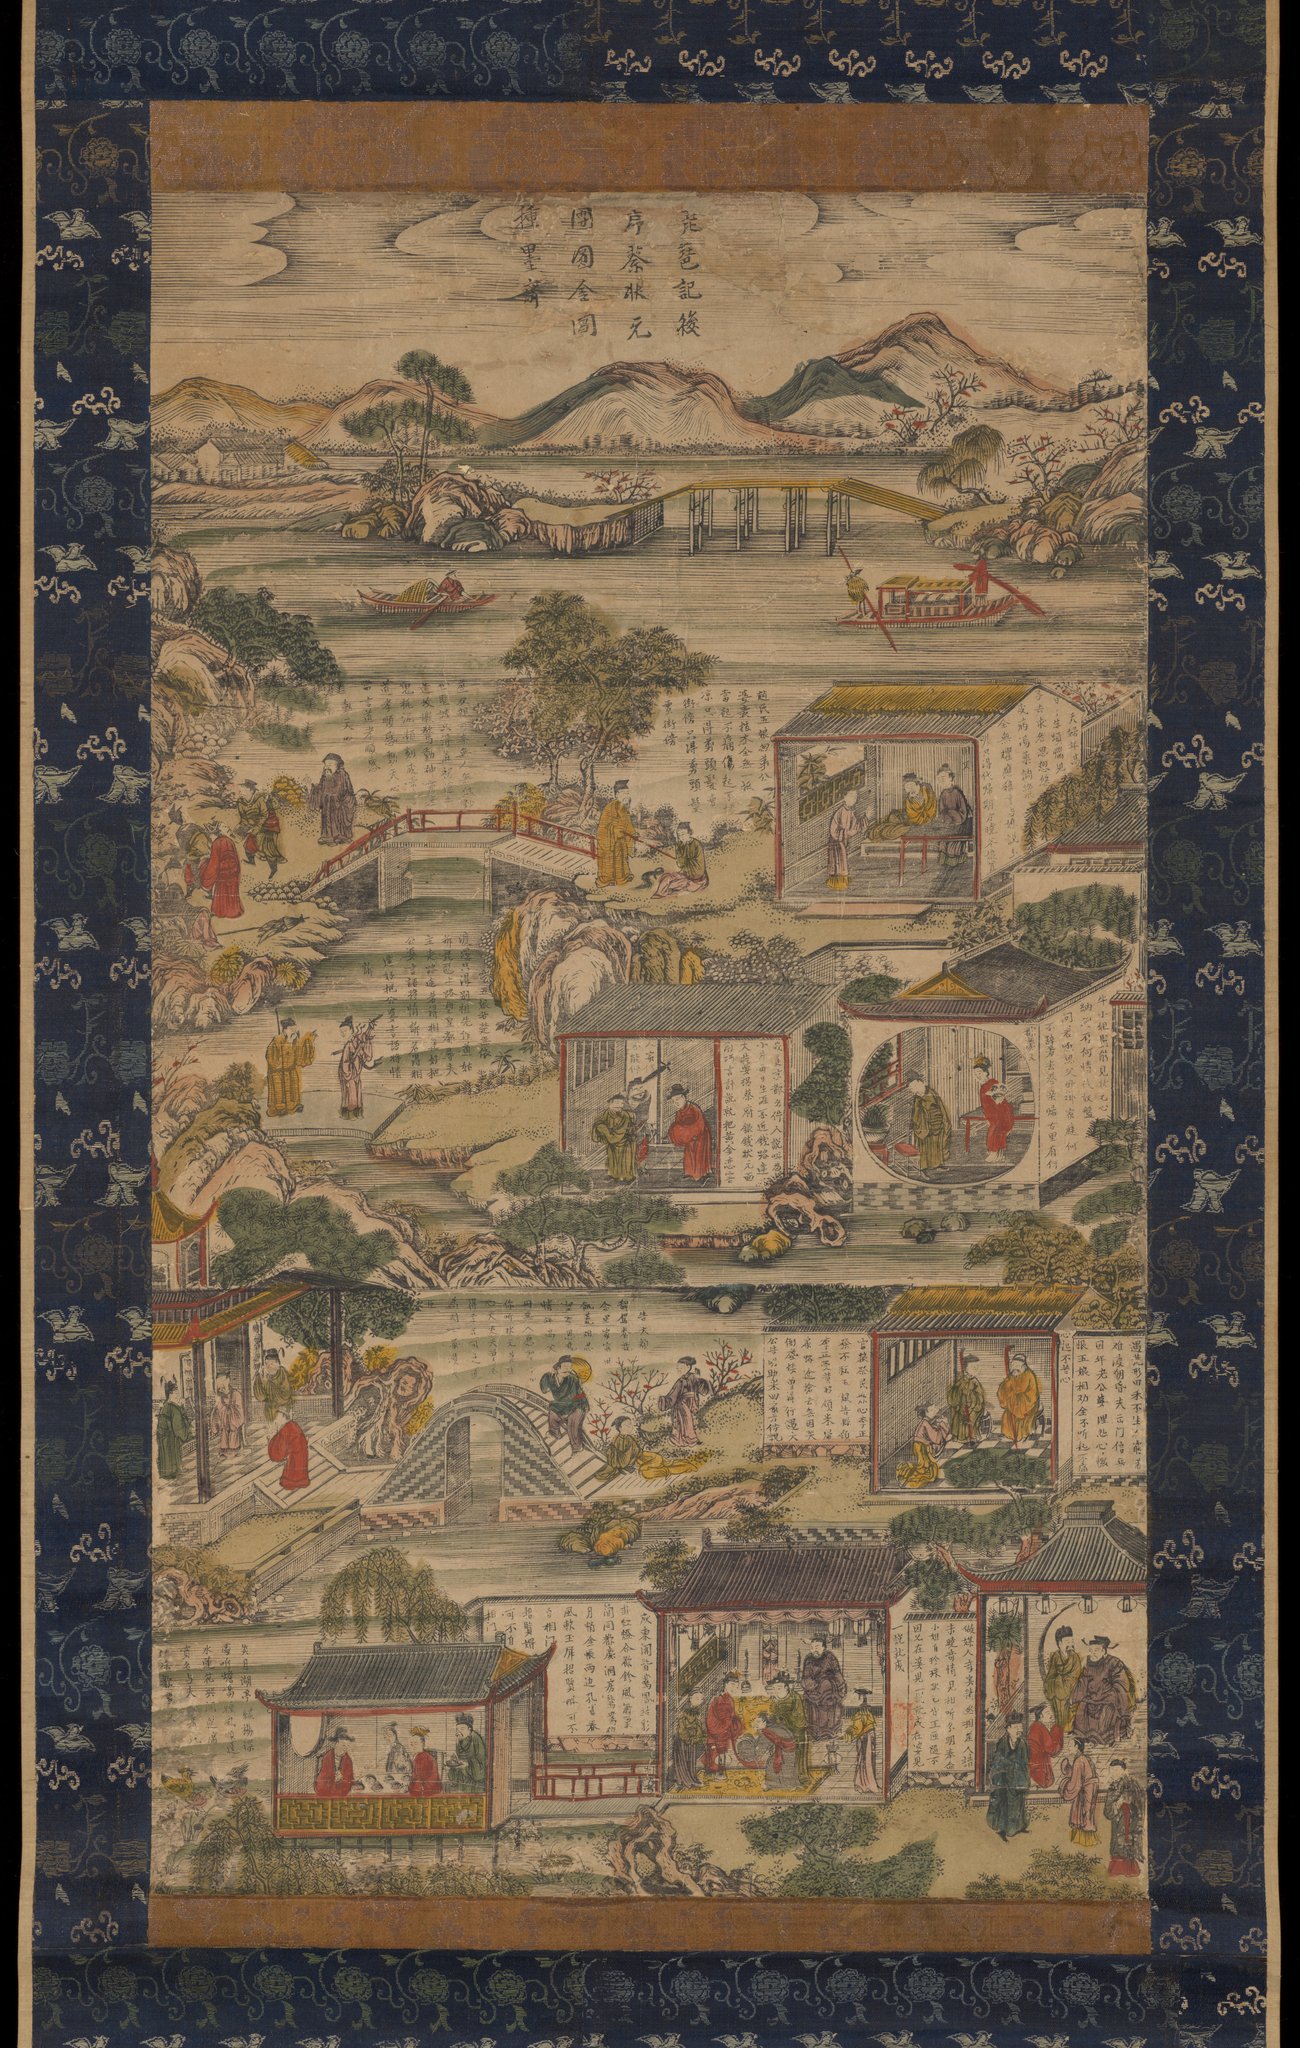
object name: print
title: Second Part of The Story of the Lute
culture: chinese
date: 1736-1795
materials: ink, paper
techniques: hand coloring, woodblock print